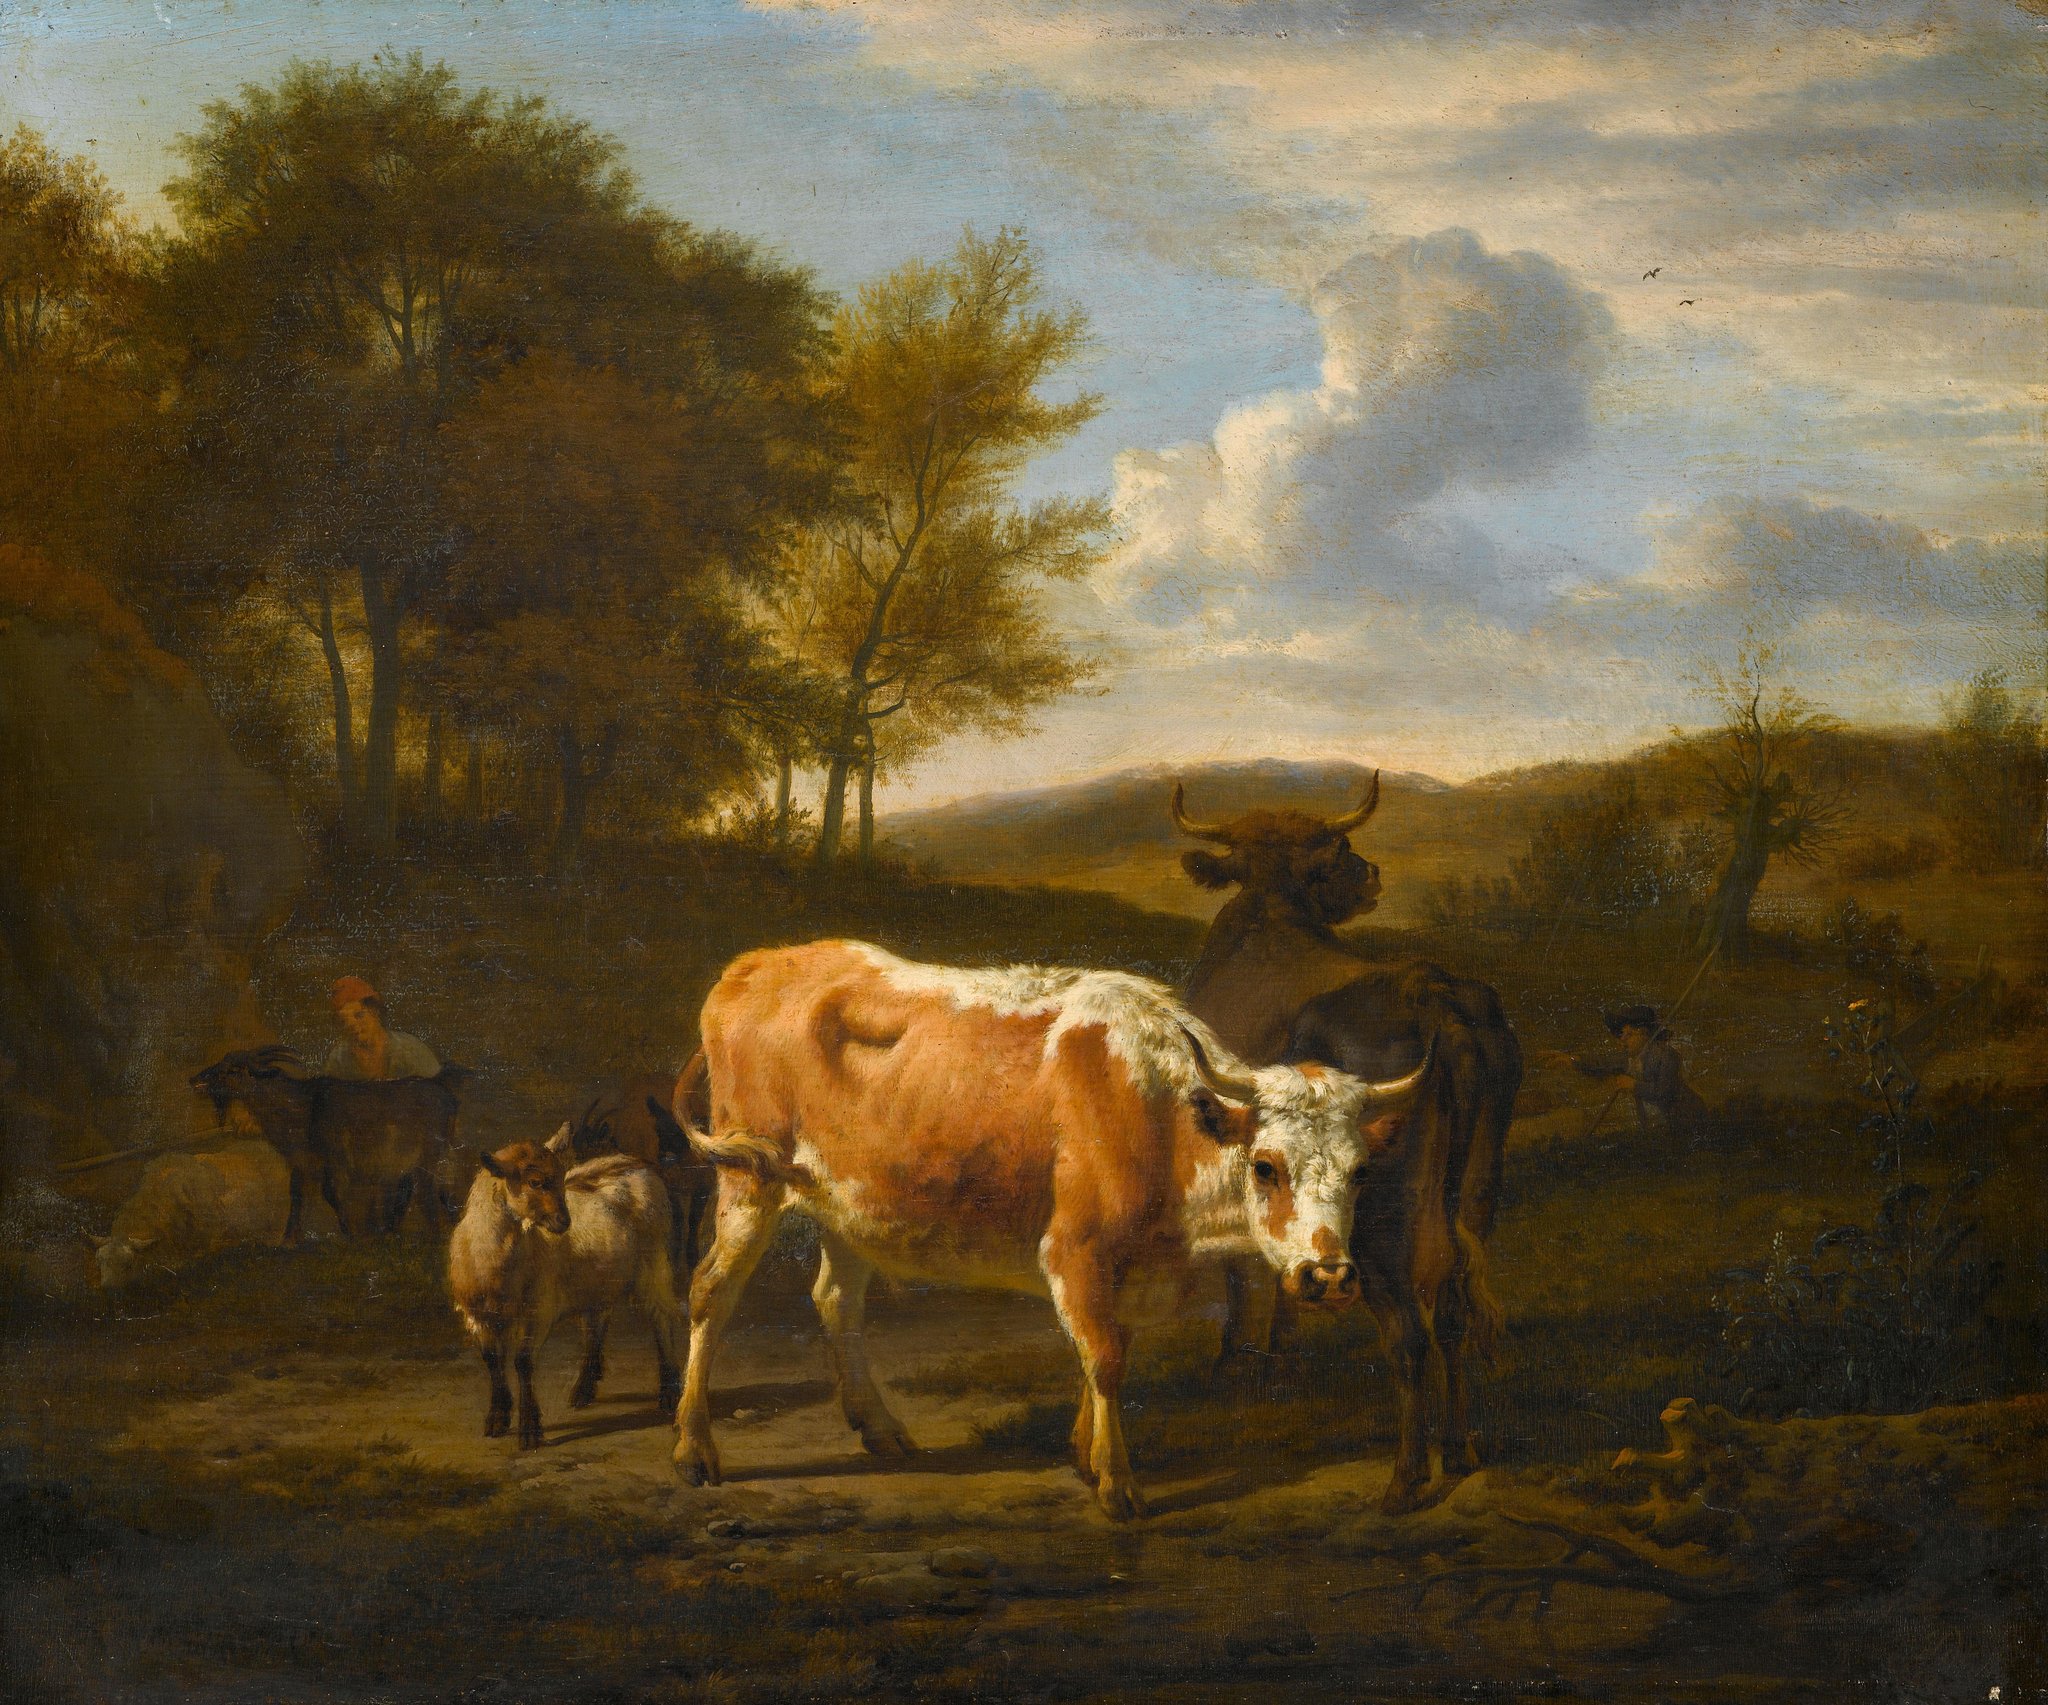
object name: painting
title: Mountainous Landscape with Cows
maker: adriaen van de velde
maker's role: draughtsman, painter, print maker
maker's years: 1636-1672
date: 1663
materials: oil, panel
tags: herding, herdsman, herdswoman, shepherd, shepherdess, cowherd, etc., goat, bovine cattle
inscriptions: signature and date: ‘A. v. Velde f. 1663’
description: Bergachtig landschap met vee. Herders met enkele koeien en geiten op een weg in een heuvelachtig landschap.